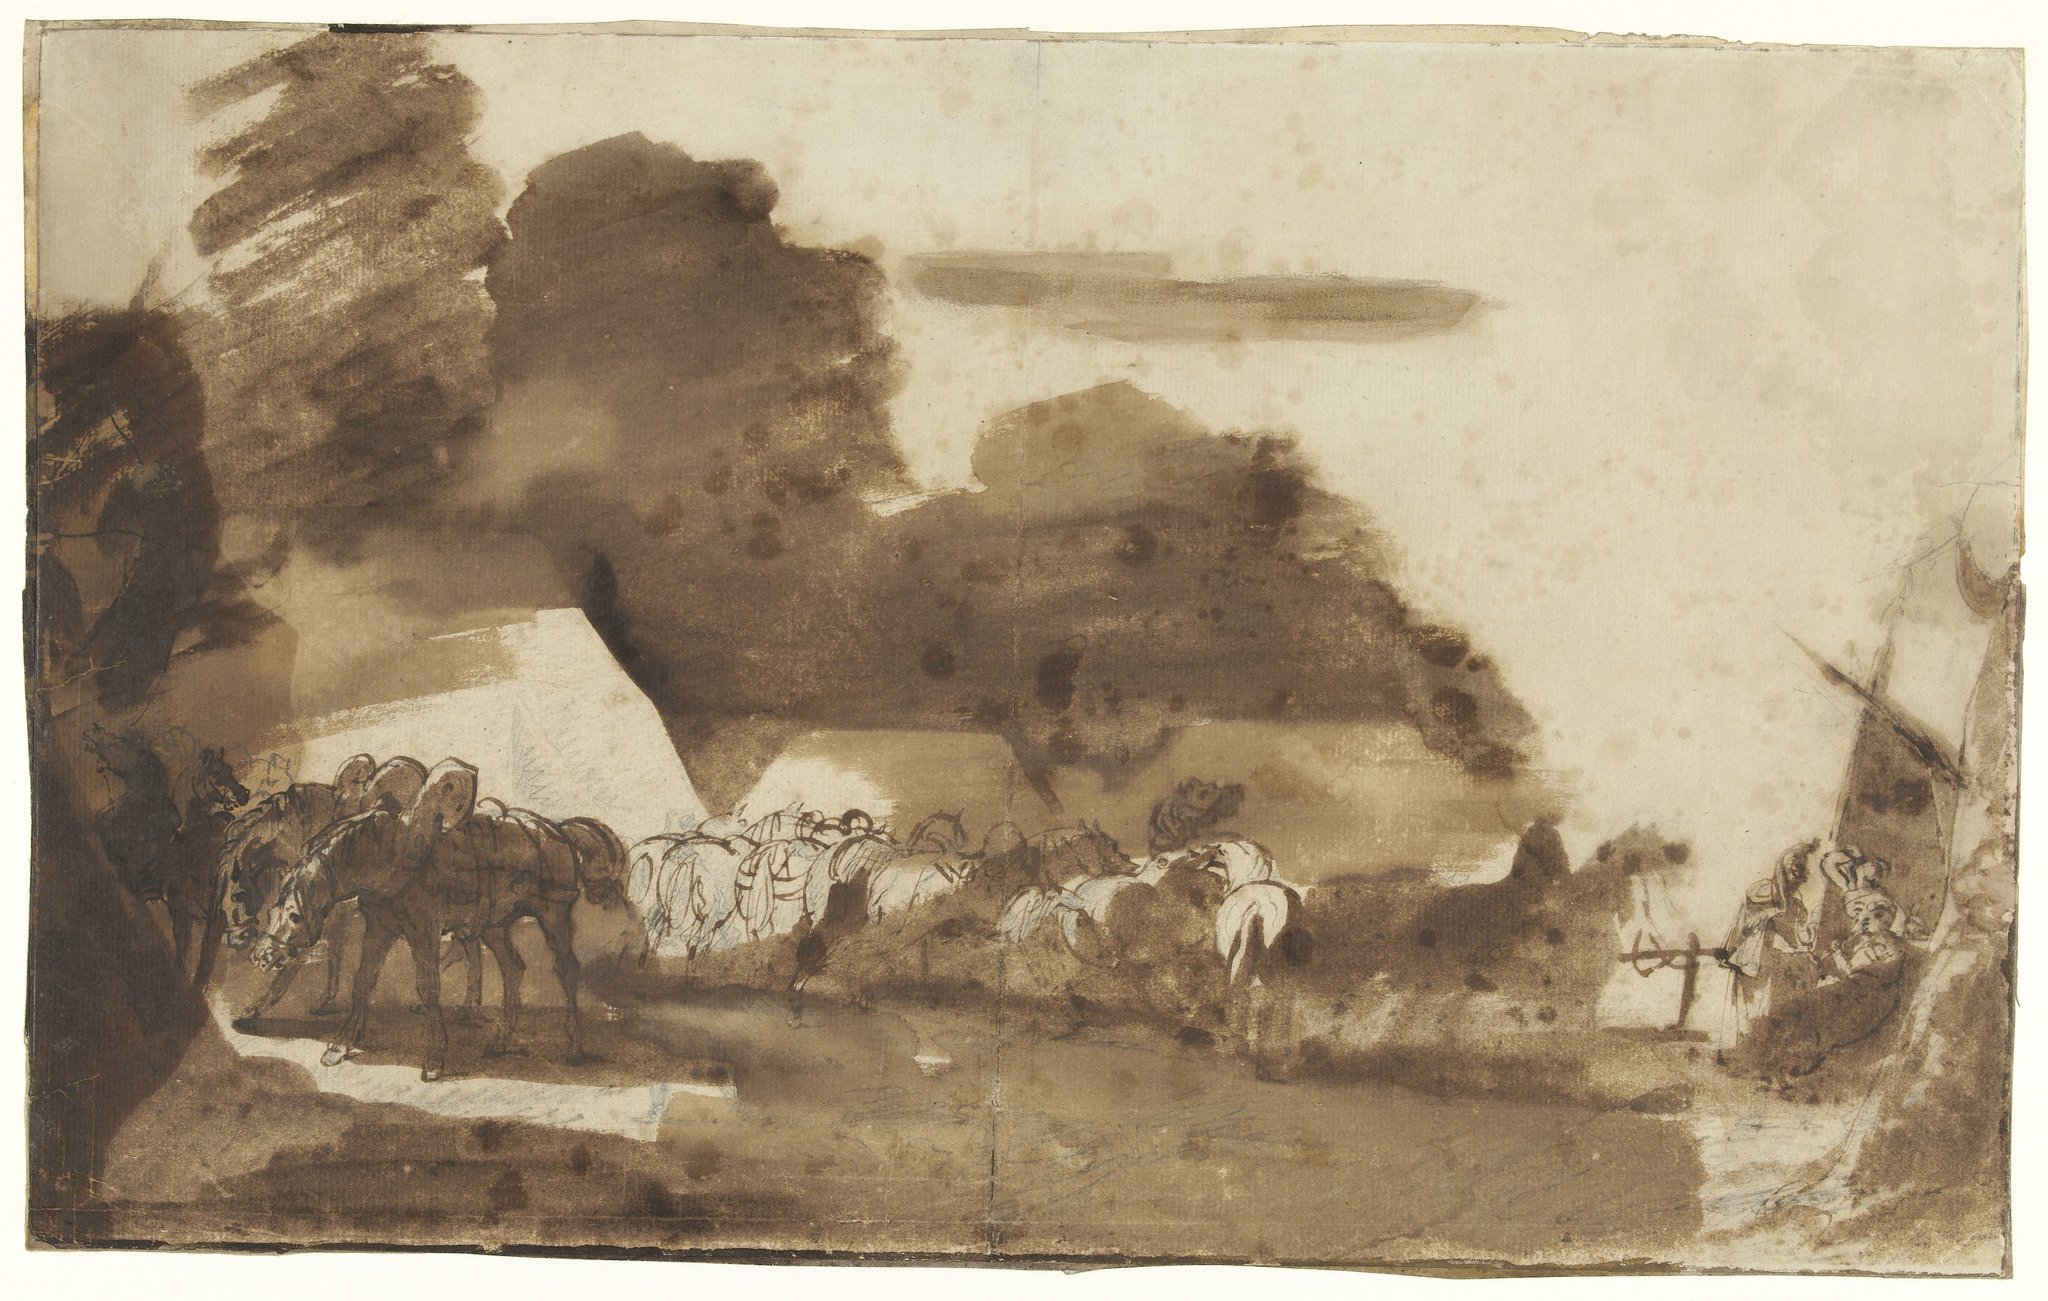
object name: drawing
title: Bivak met paarden en soldaten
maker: théodore géricault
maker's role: draughtsman, print maker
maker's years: 1791-1824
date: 1812-1818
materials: ink, paper, pencil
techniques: brush, pen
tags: (military) camp with tents